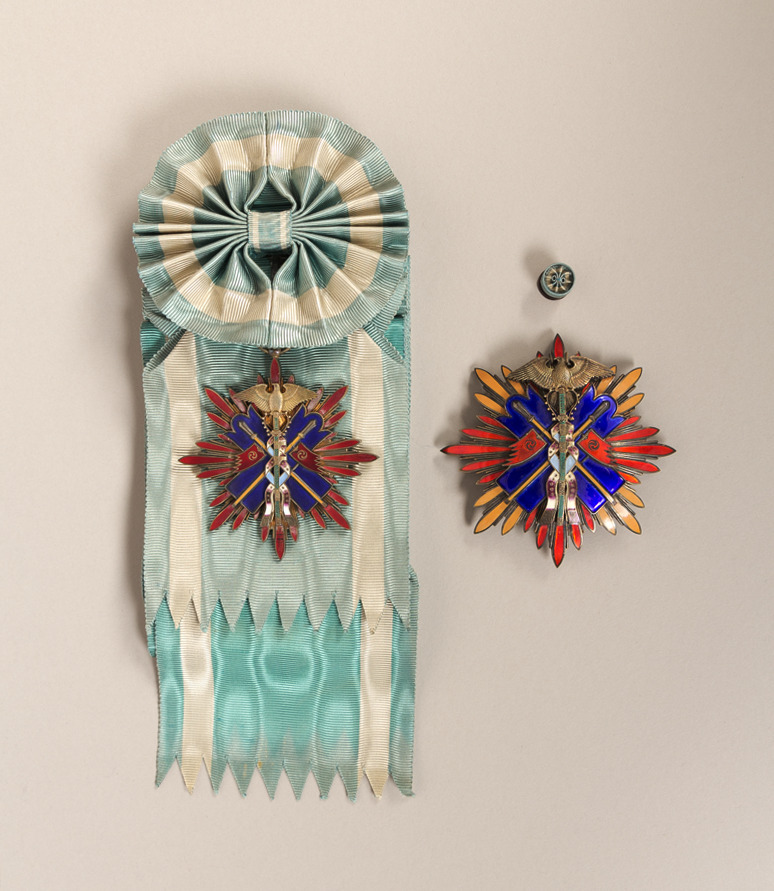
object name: insignia, medal and button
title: Insignia of the Order of the Golden Kite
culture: japanese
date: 1867-1900